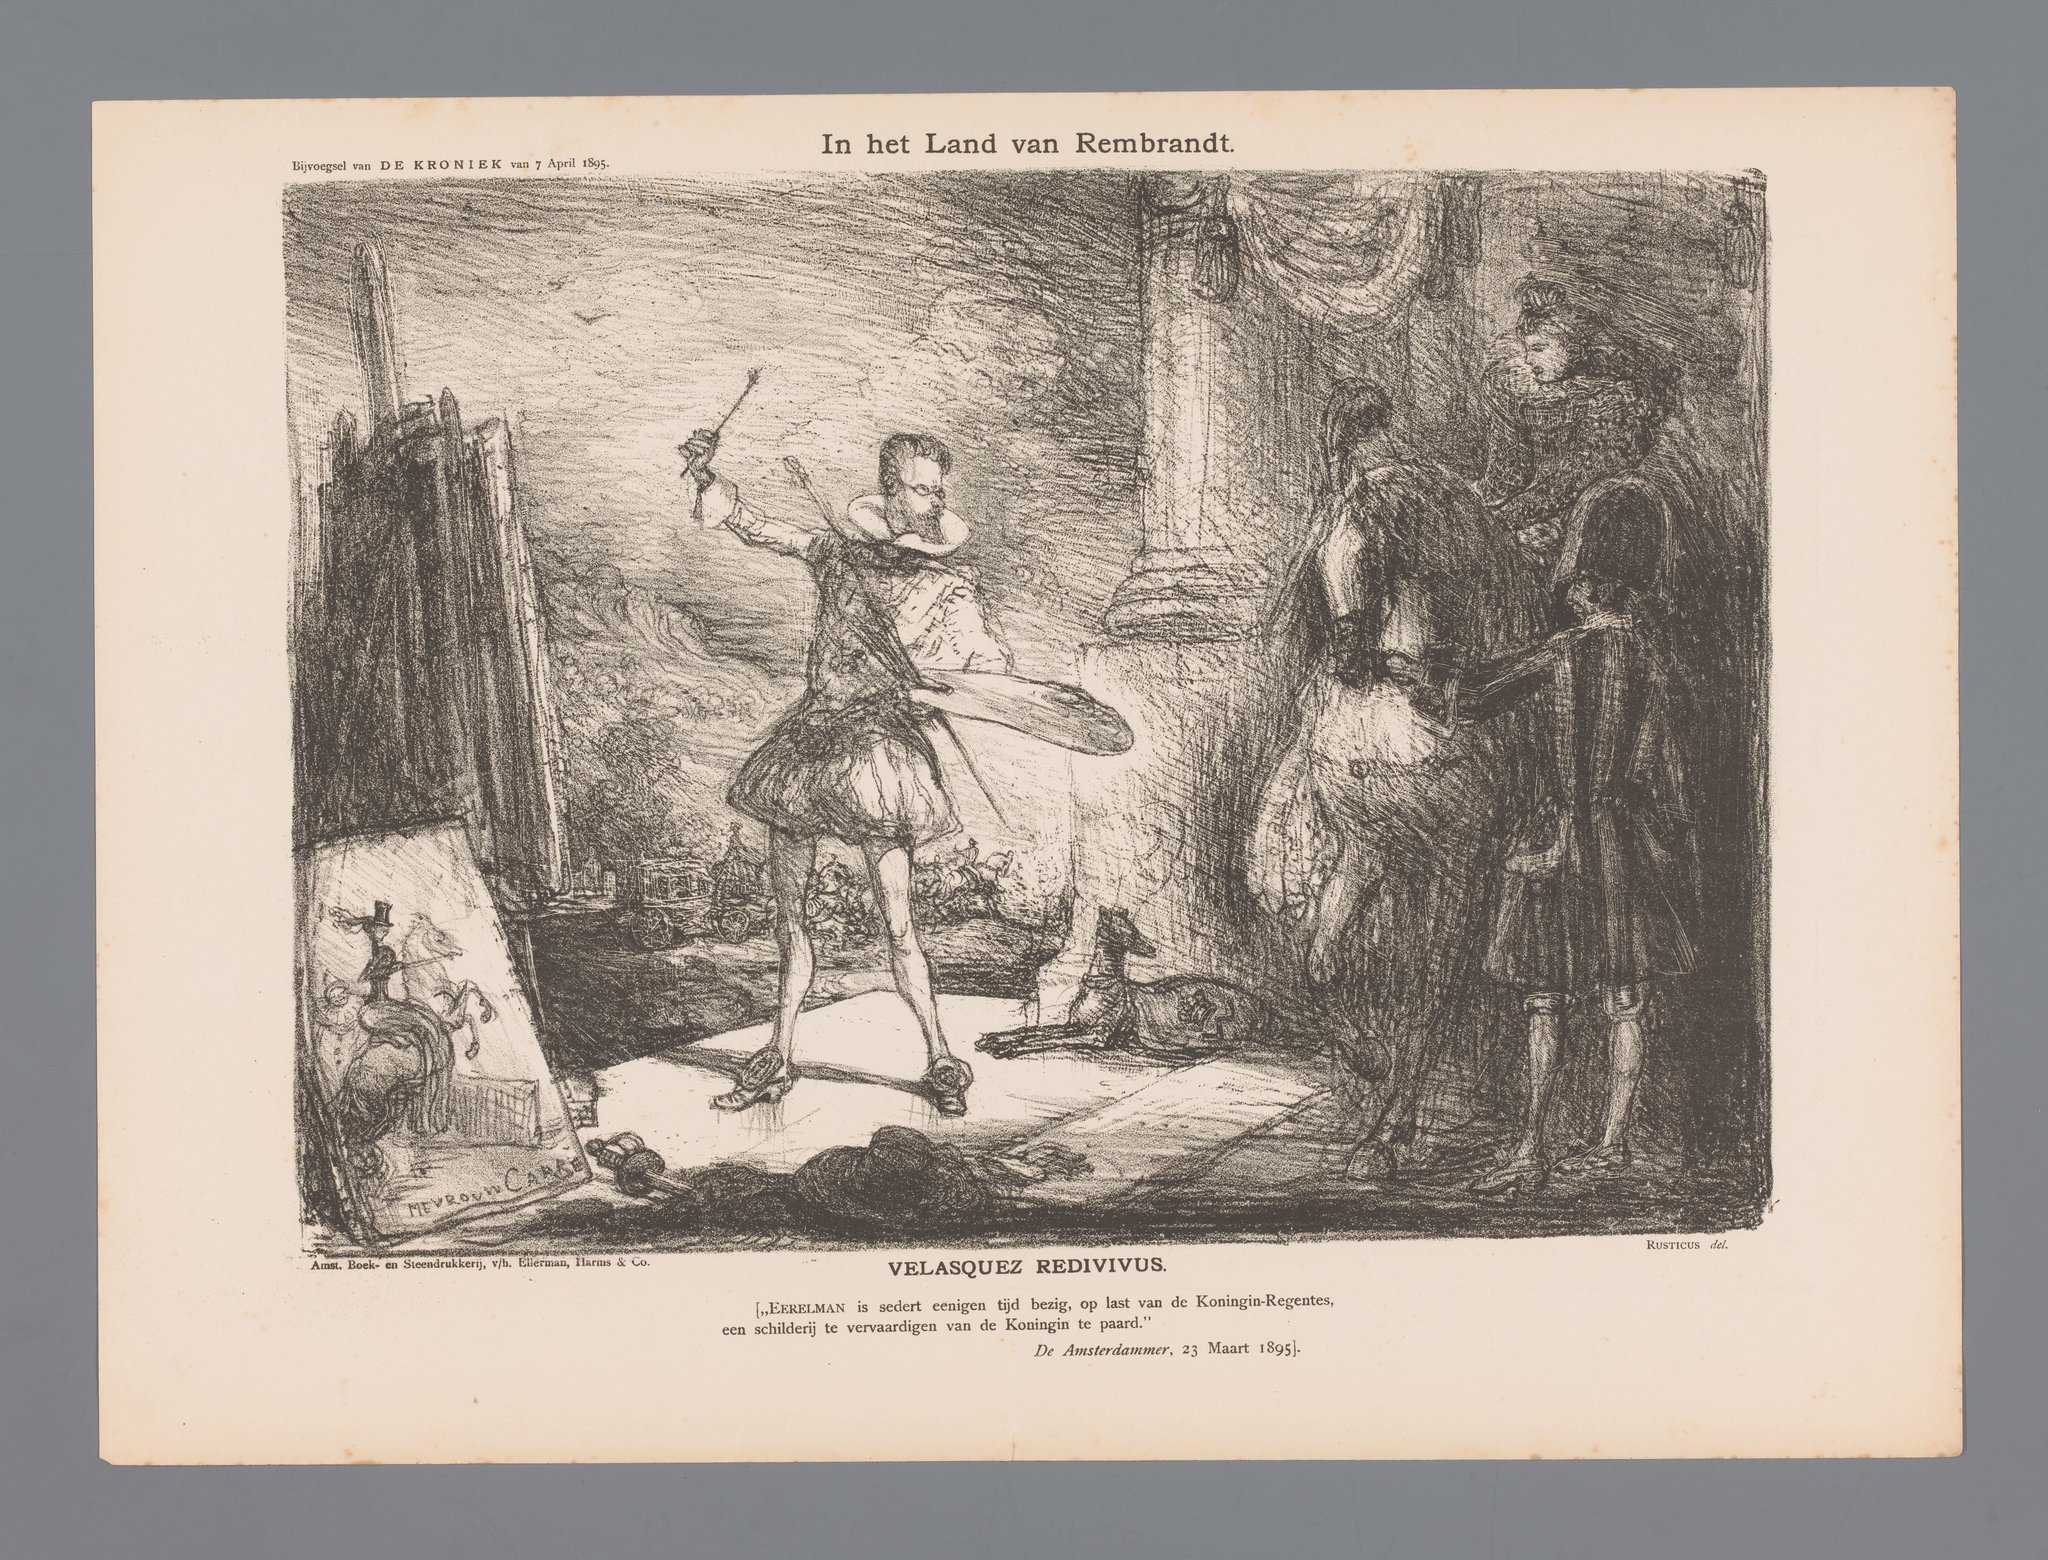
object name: cartoon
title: In het Land van Rembrandt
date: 1895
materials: paper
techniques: lithograph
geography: amsterdam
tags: wilhelmina of the netherlands, painter, otto eerelman, equestrian state-portrait, political caricatures and satires, painter working from clothed model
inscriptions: date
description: Spotprent op de schilder Eerelman die het ruiterportret van de jonge Wilhelmina schildert. Eerelman voorgesteld als Velasquez staande voor zijn ezel, linksvoor op de grond een portret van mevrouw Carré te paard. Onderaan vier regels tekst. Verschenen in de bijvoegsel van 'De Kroniek' van 7 april 1895.